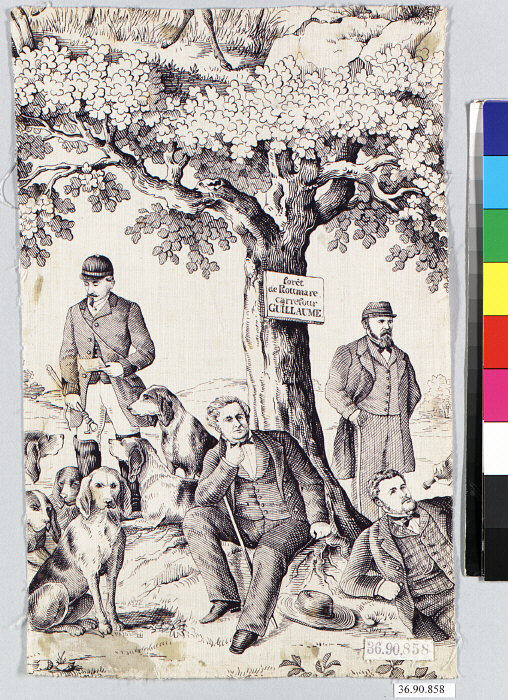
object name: piece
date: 1801-1900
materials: cotton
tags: men,hunting,dogs